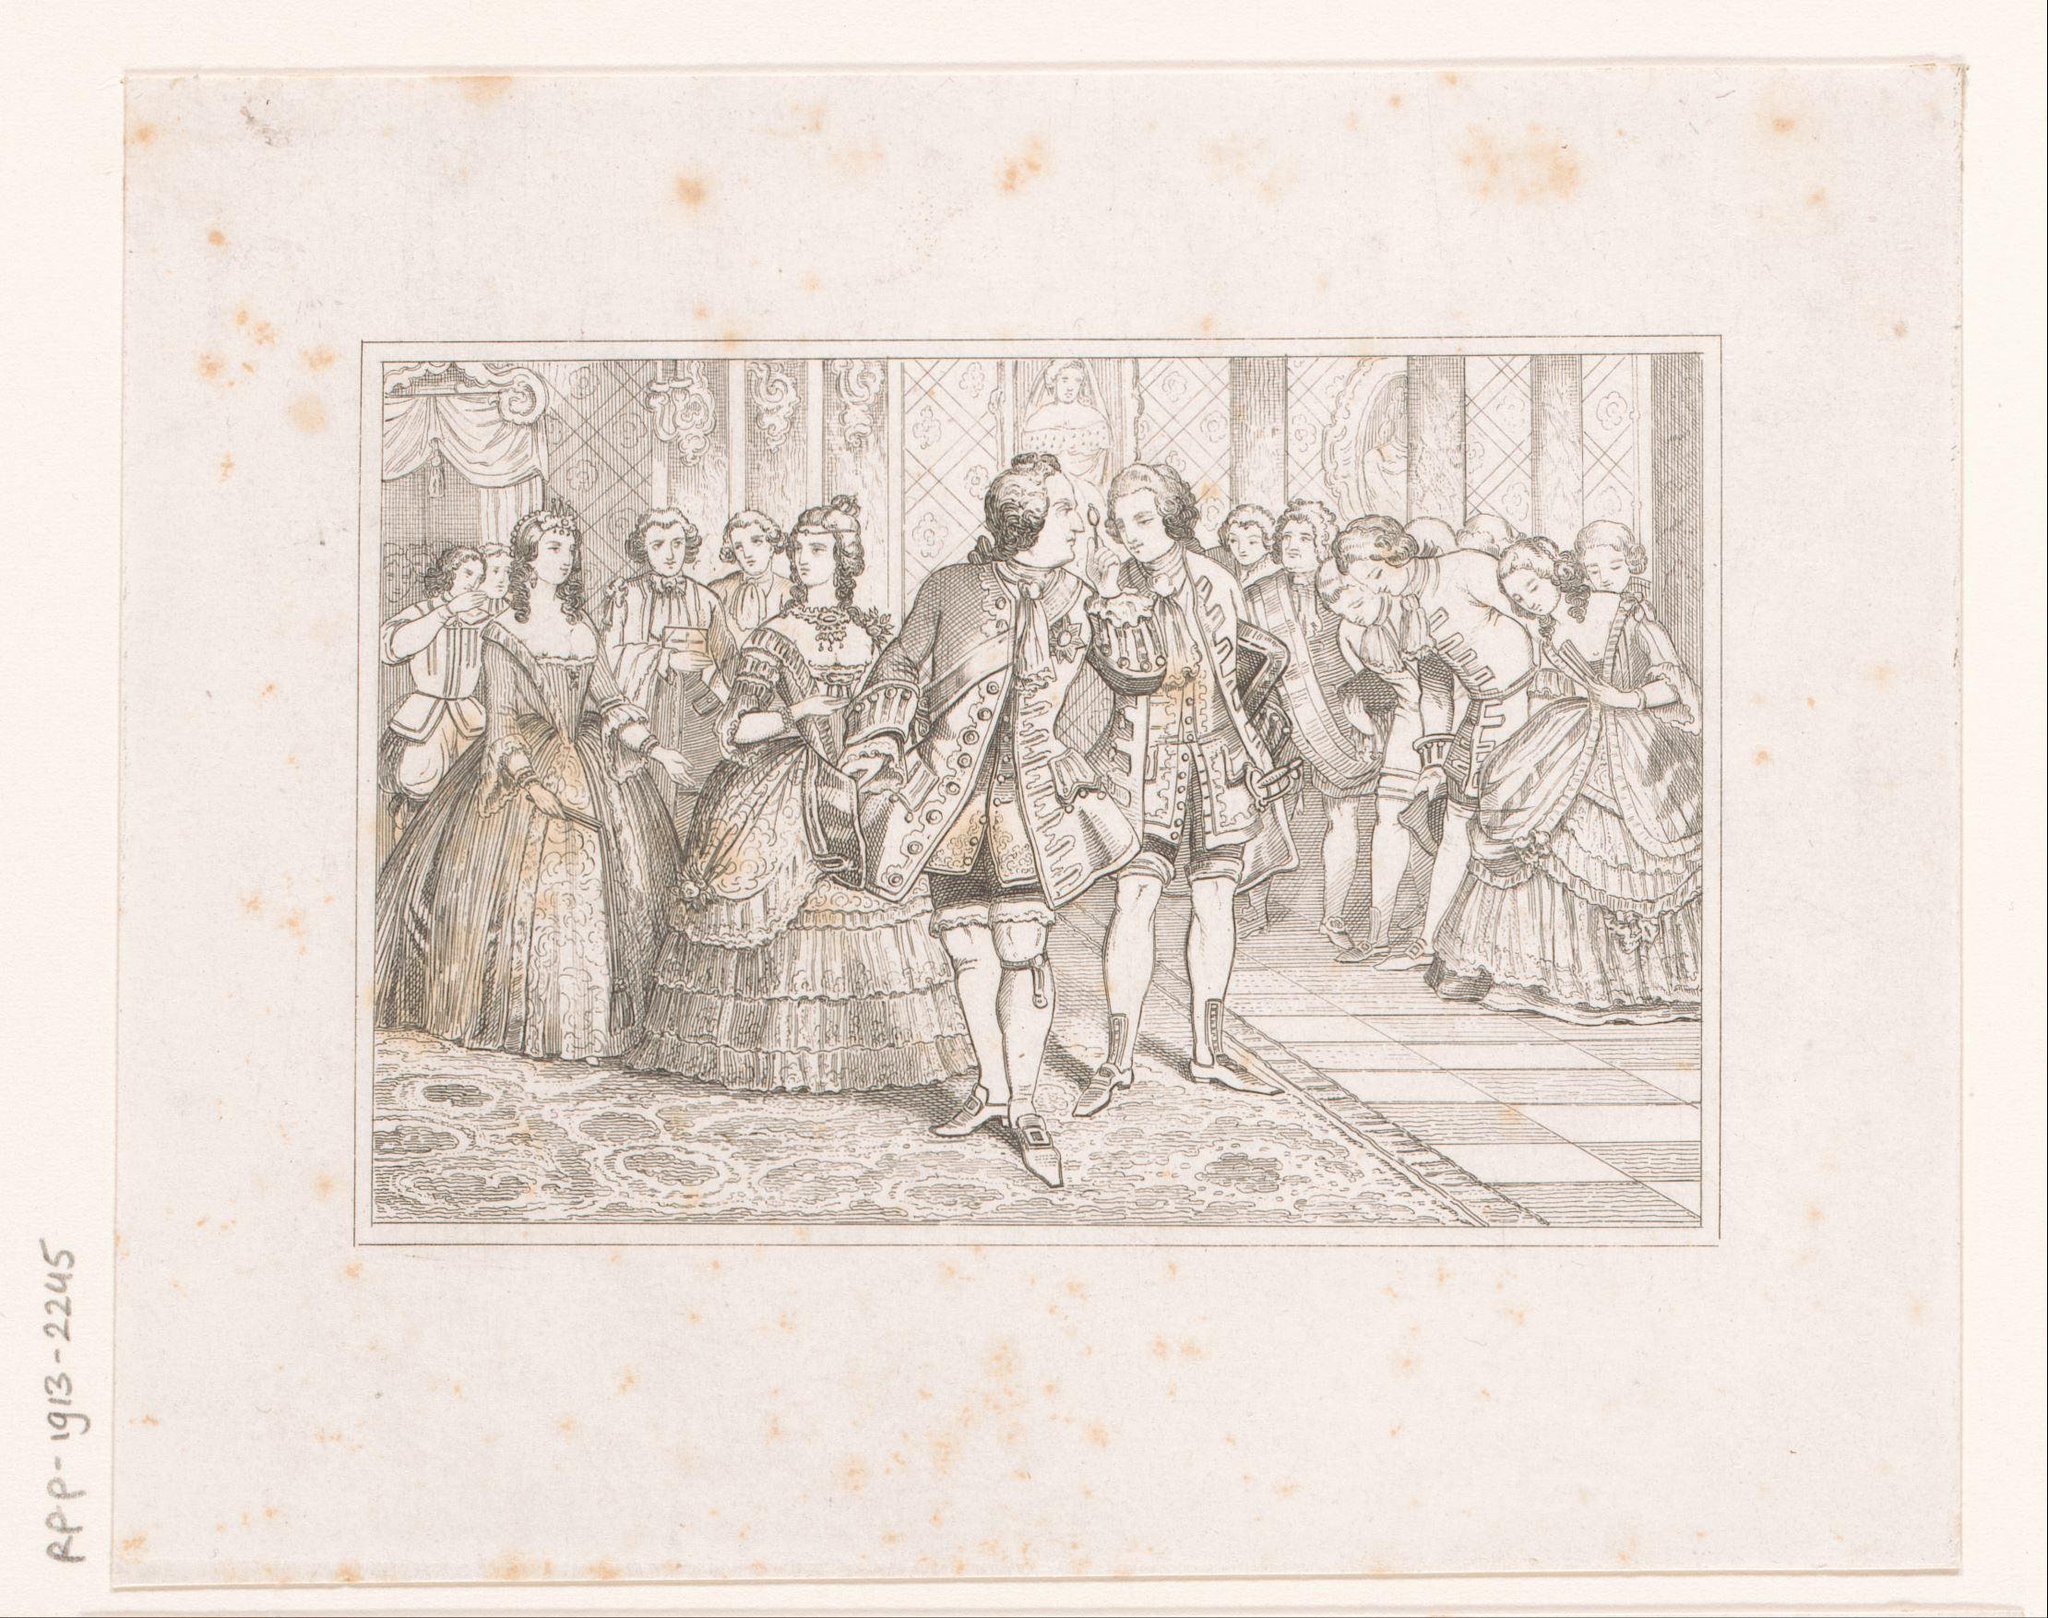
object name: print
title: Gezelschap van welgestelde mannen en vrouwen in een rijkelijk interieur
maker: auguste numans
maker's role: print maker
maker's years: 1823-1883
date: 1833-1880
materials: paper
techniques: etching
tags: head bent forward; bowing, interior ~ representation of a building, festivities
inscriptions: collector's mark: Lugt 2228